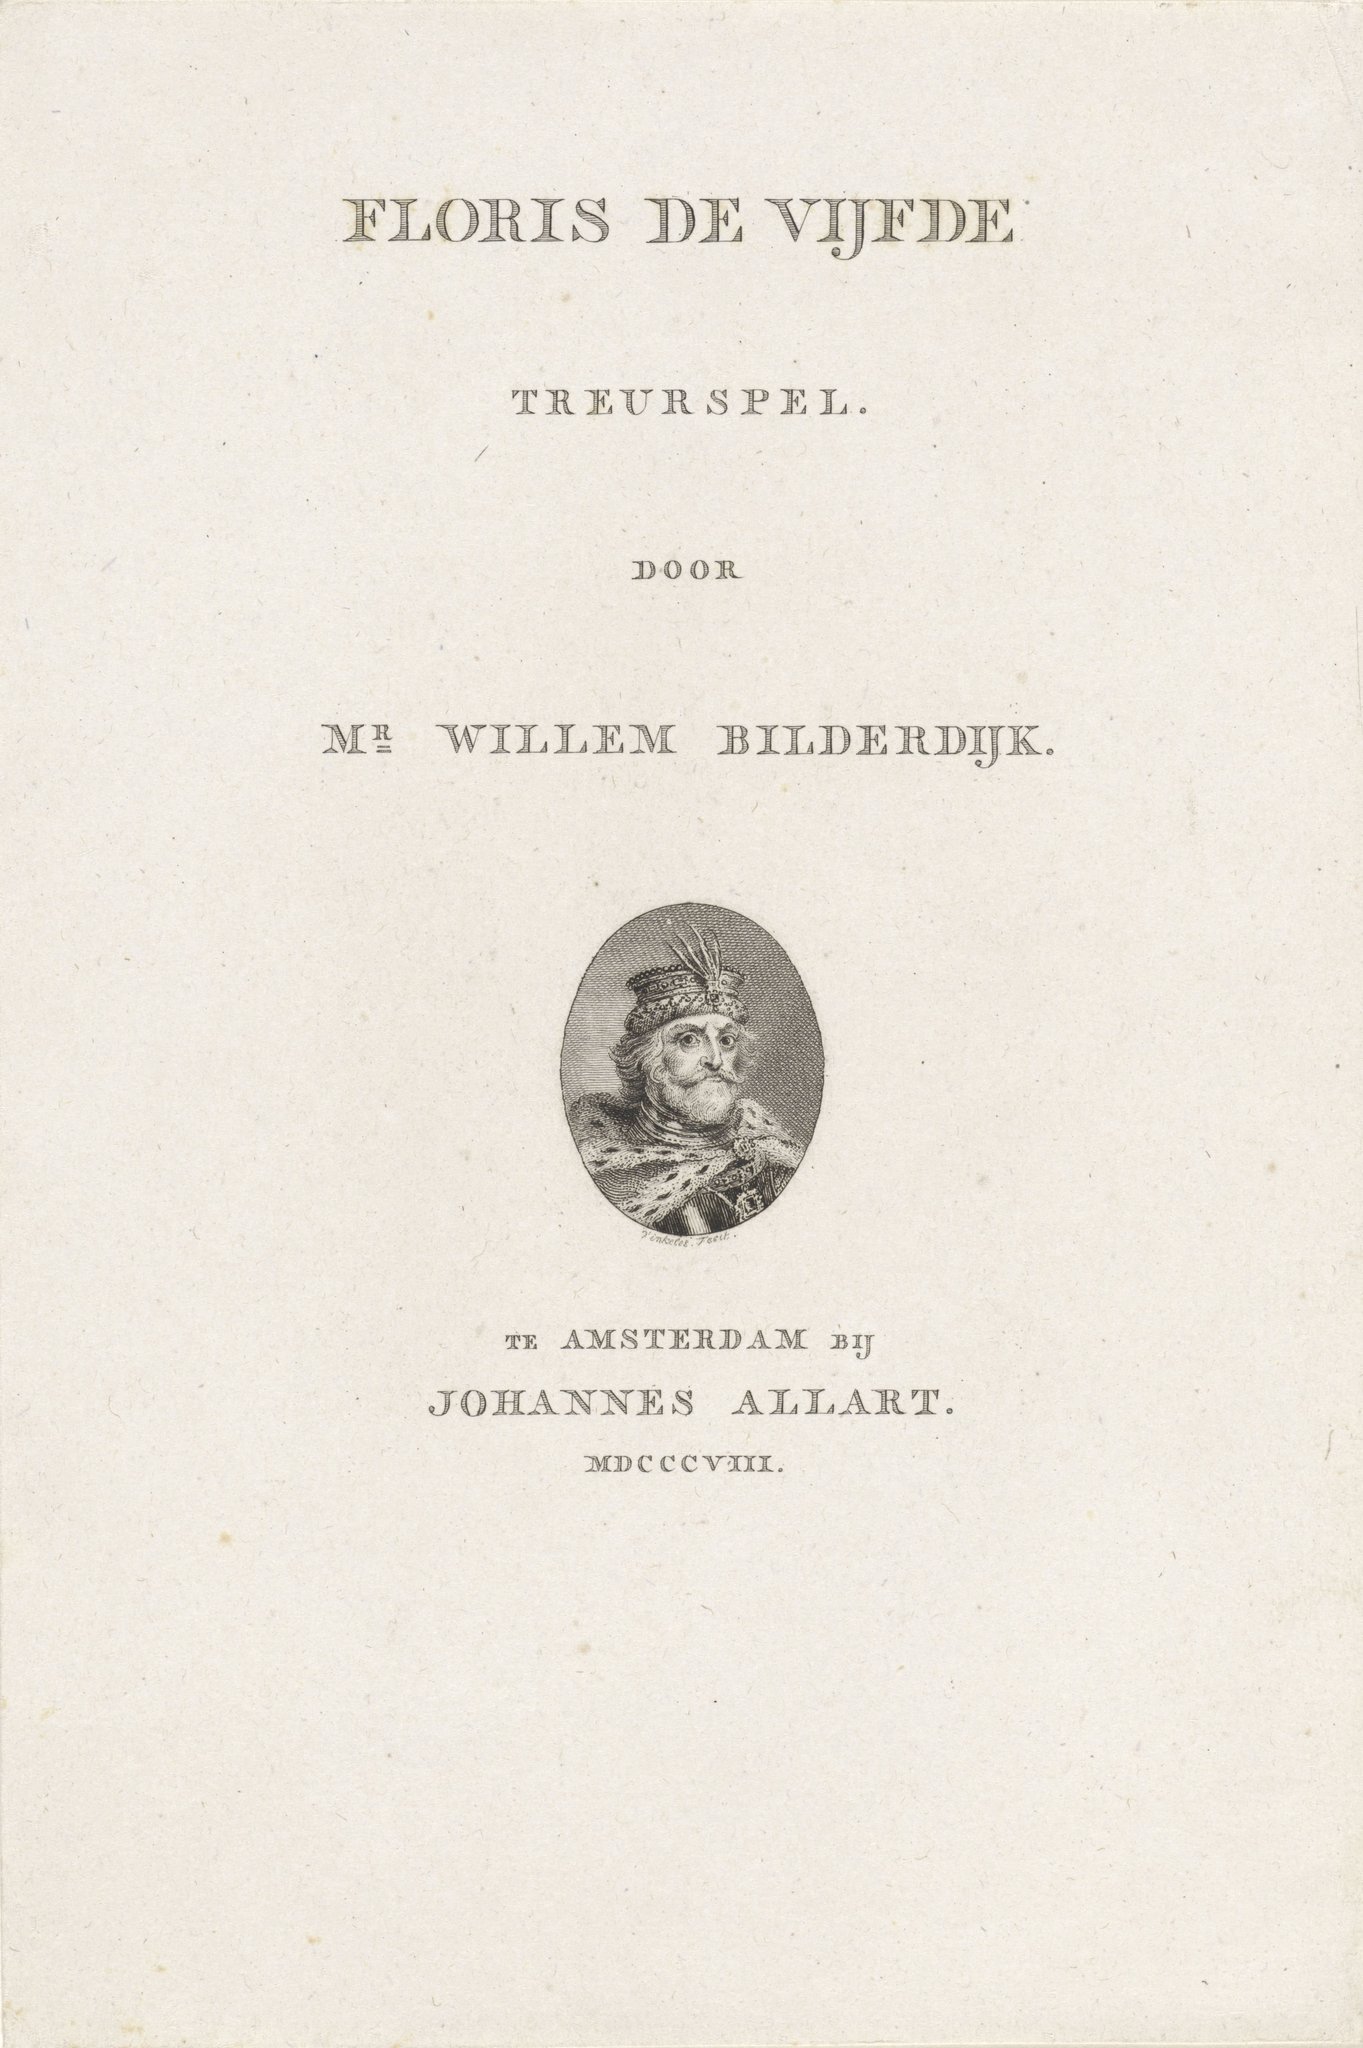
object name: print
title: Titelpagina voor: W. Bilderdijk, Floris de Vijfde treurspel, 1808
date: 1808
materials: paper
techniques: etching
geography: amsterdam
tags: leiden, floris v (graaf van holland en zeeland)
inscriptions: collector's mark: Lugt 2228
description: Titelpagina voor: Bilderdijk, Willem. Floris de Vijfde treurspel. Amsterdam: Johannes Allart, 1808.